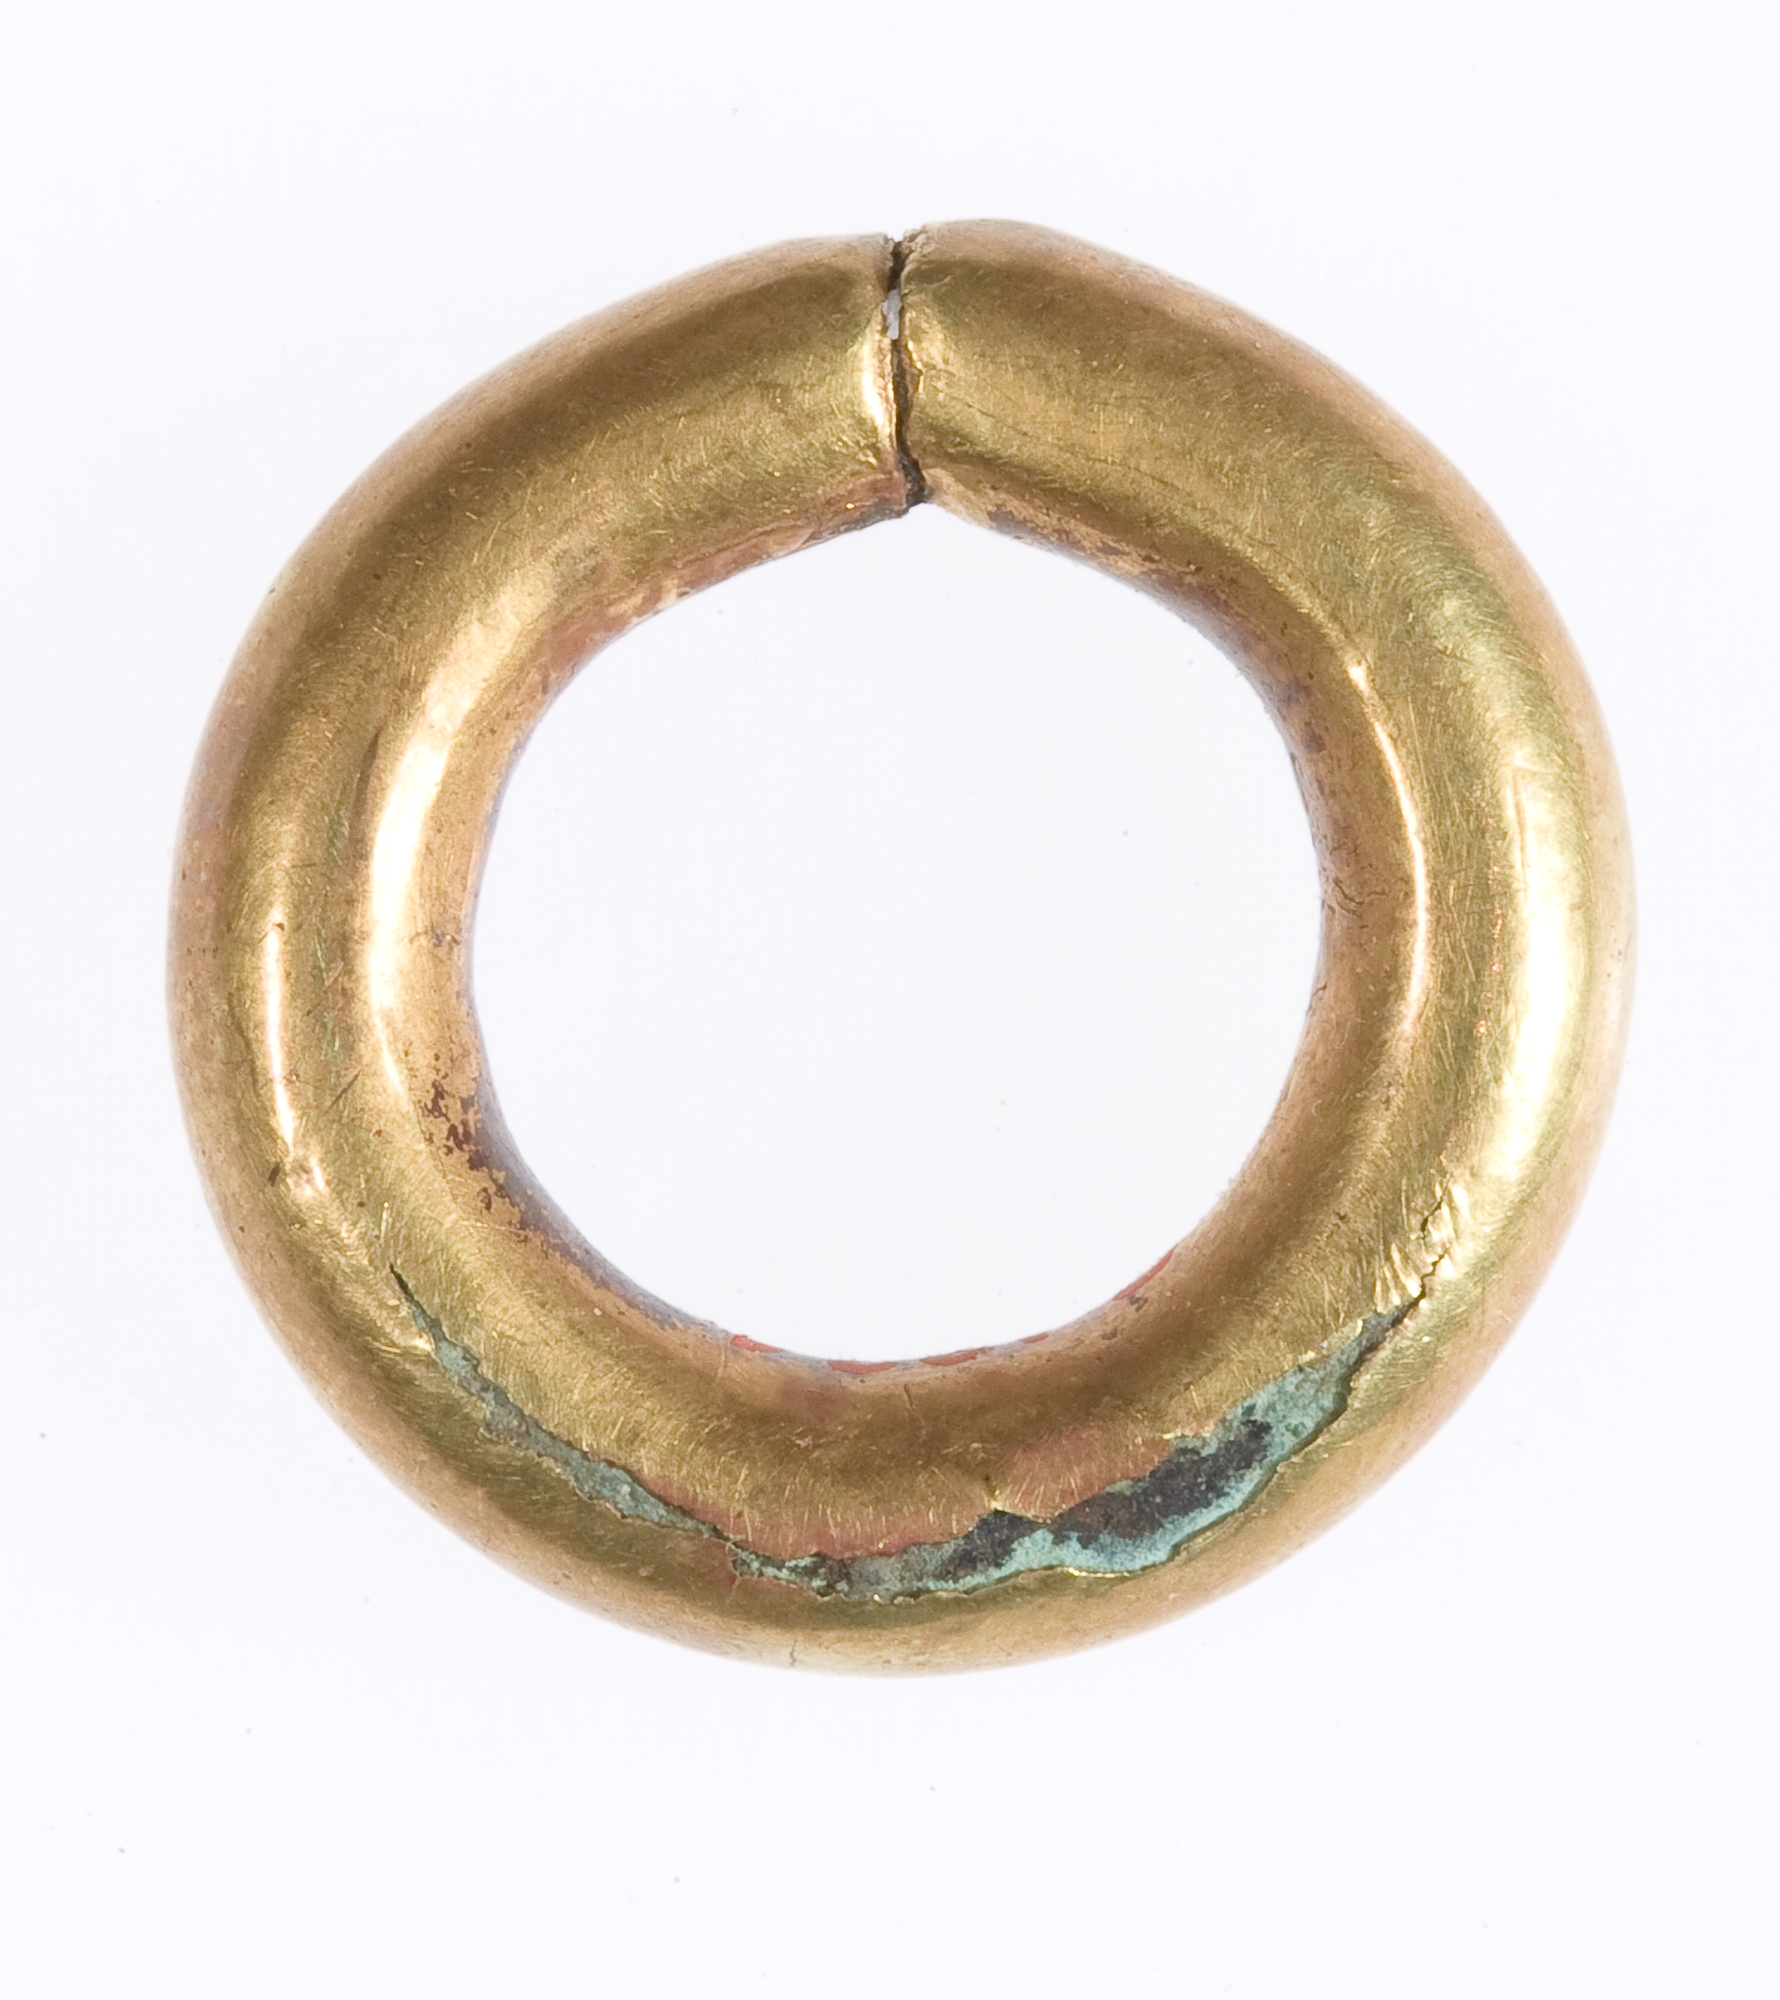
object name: earring, penannular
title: Penannular Earring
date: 1550-1425 BCE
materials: gold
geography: egypt